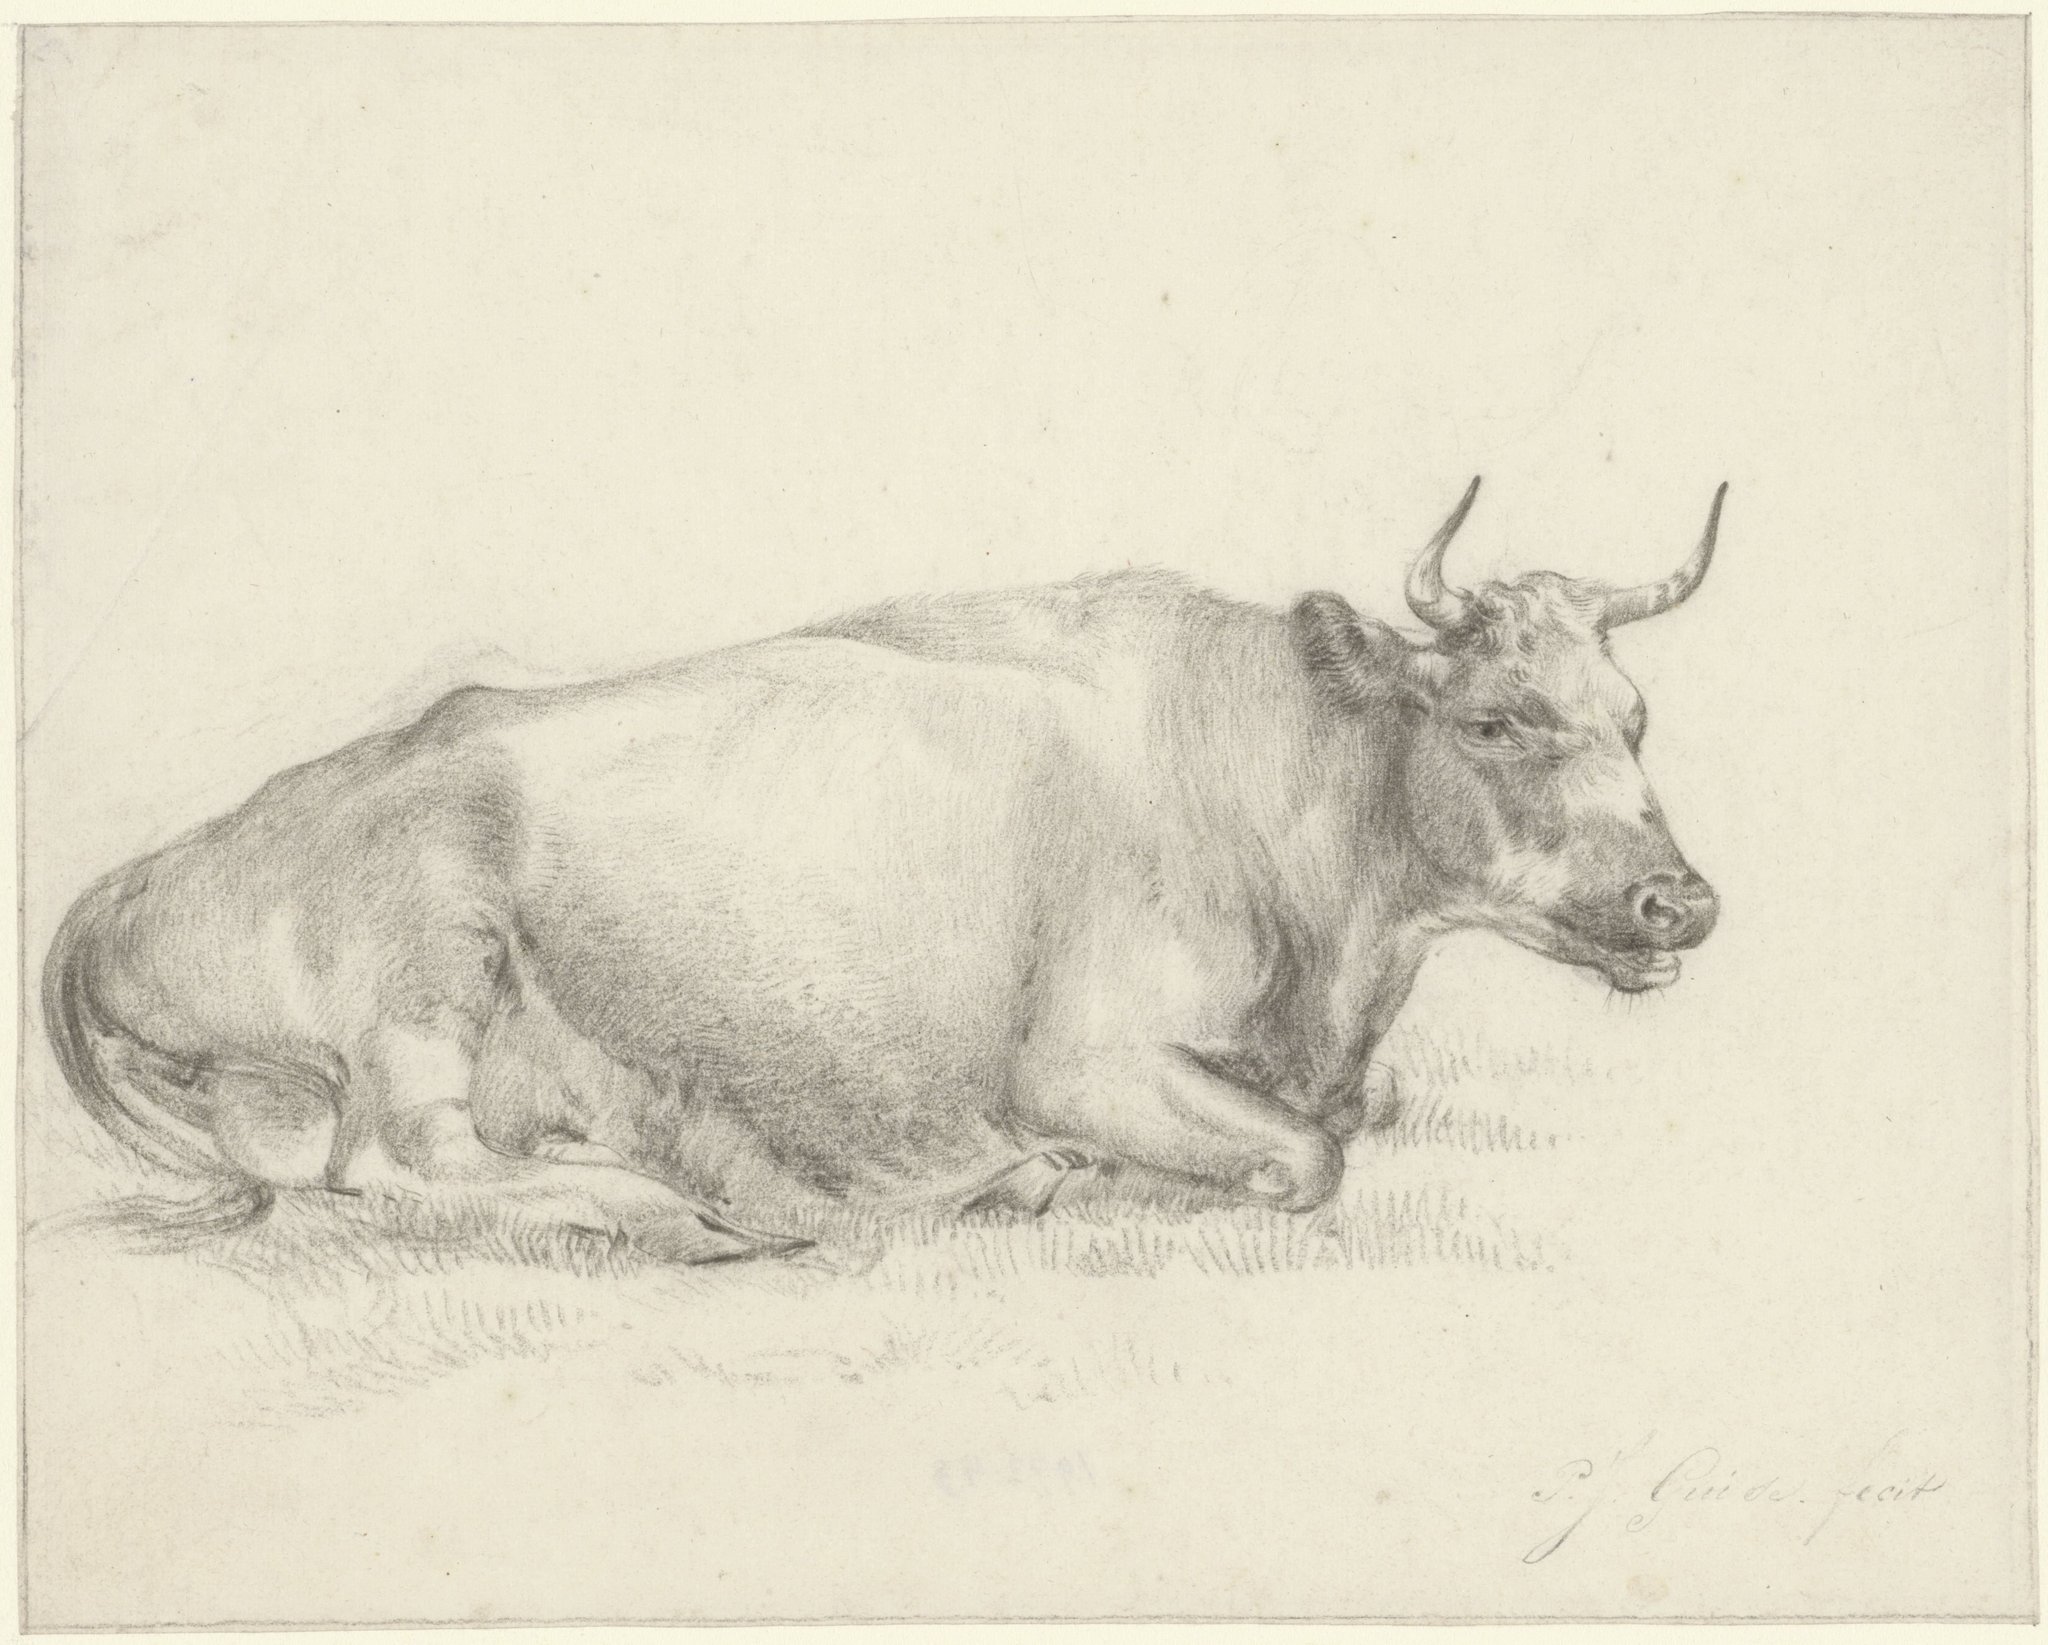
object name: drawing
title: Liggende koe, naar rechts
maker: pieter jan guise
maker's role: draughtsman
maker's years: 1814-1859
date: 1824-1859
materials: chalk, paper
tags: cow